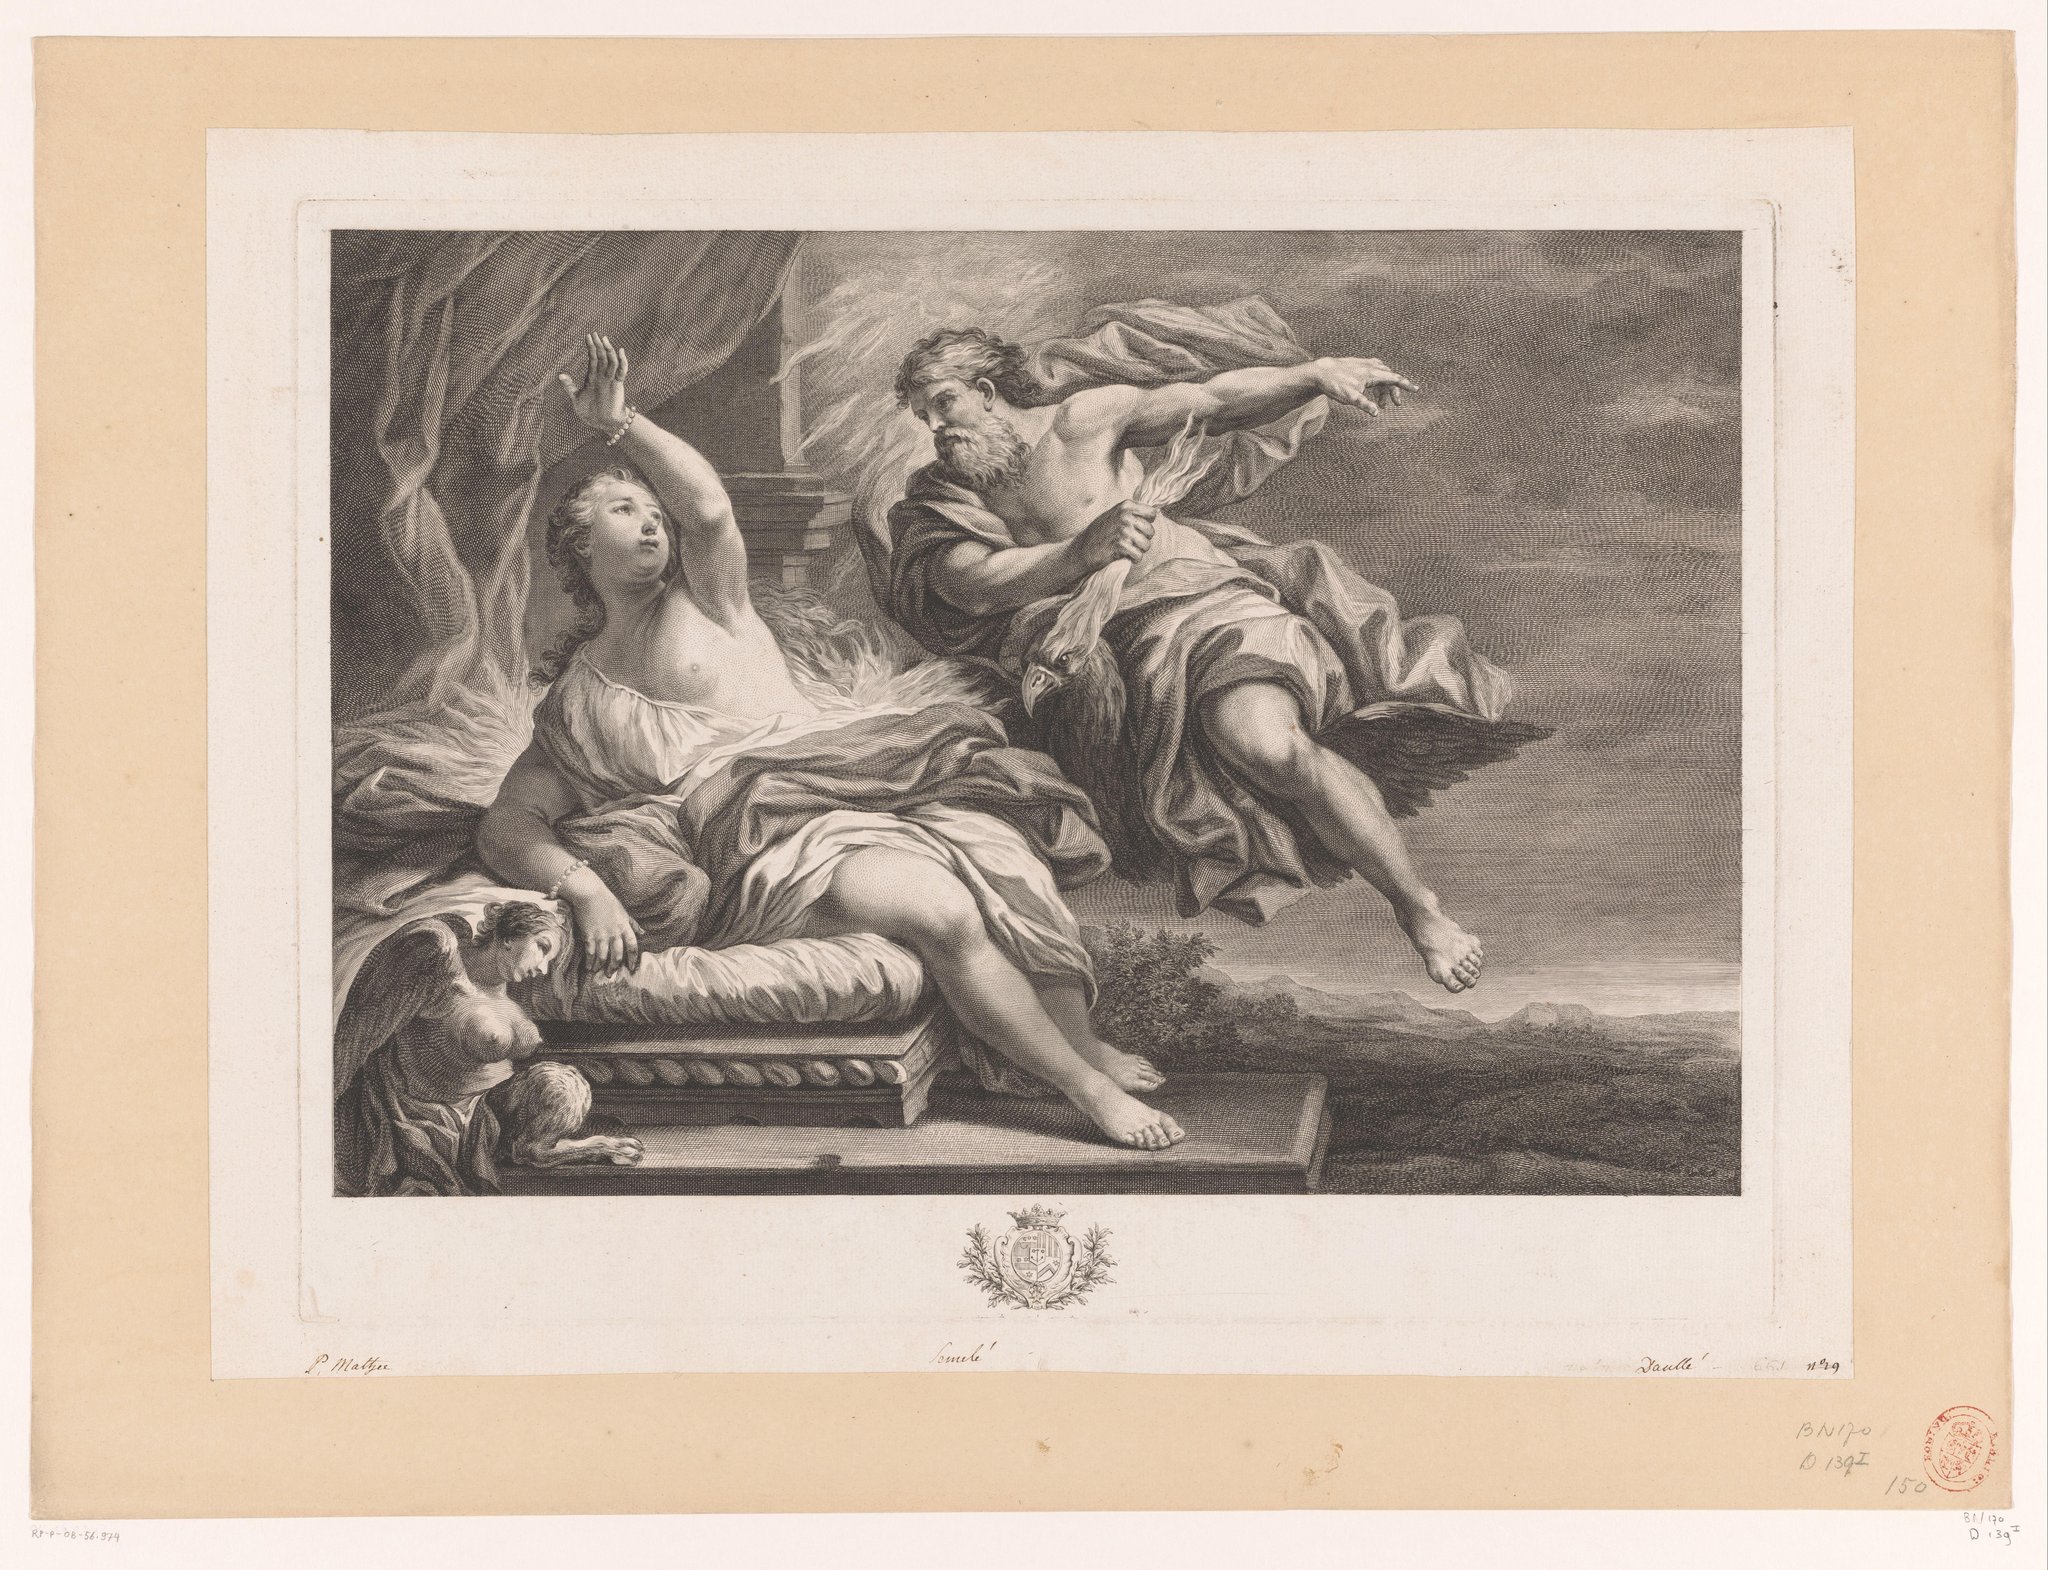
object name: print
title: Jupiter en Semele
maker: jean daullé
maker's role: print maker, publisher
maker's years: 1703-1763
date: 1762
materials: paper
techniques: engraving, etching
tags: jupiter wooing semele, armorial bearing, heraldry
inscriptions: collector's mark: Lugt 240